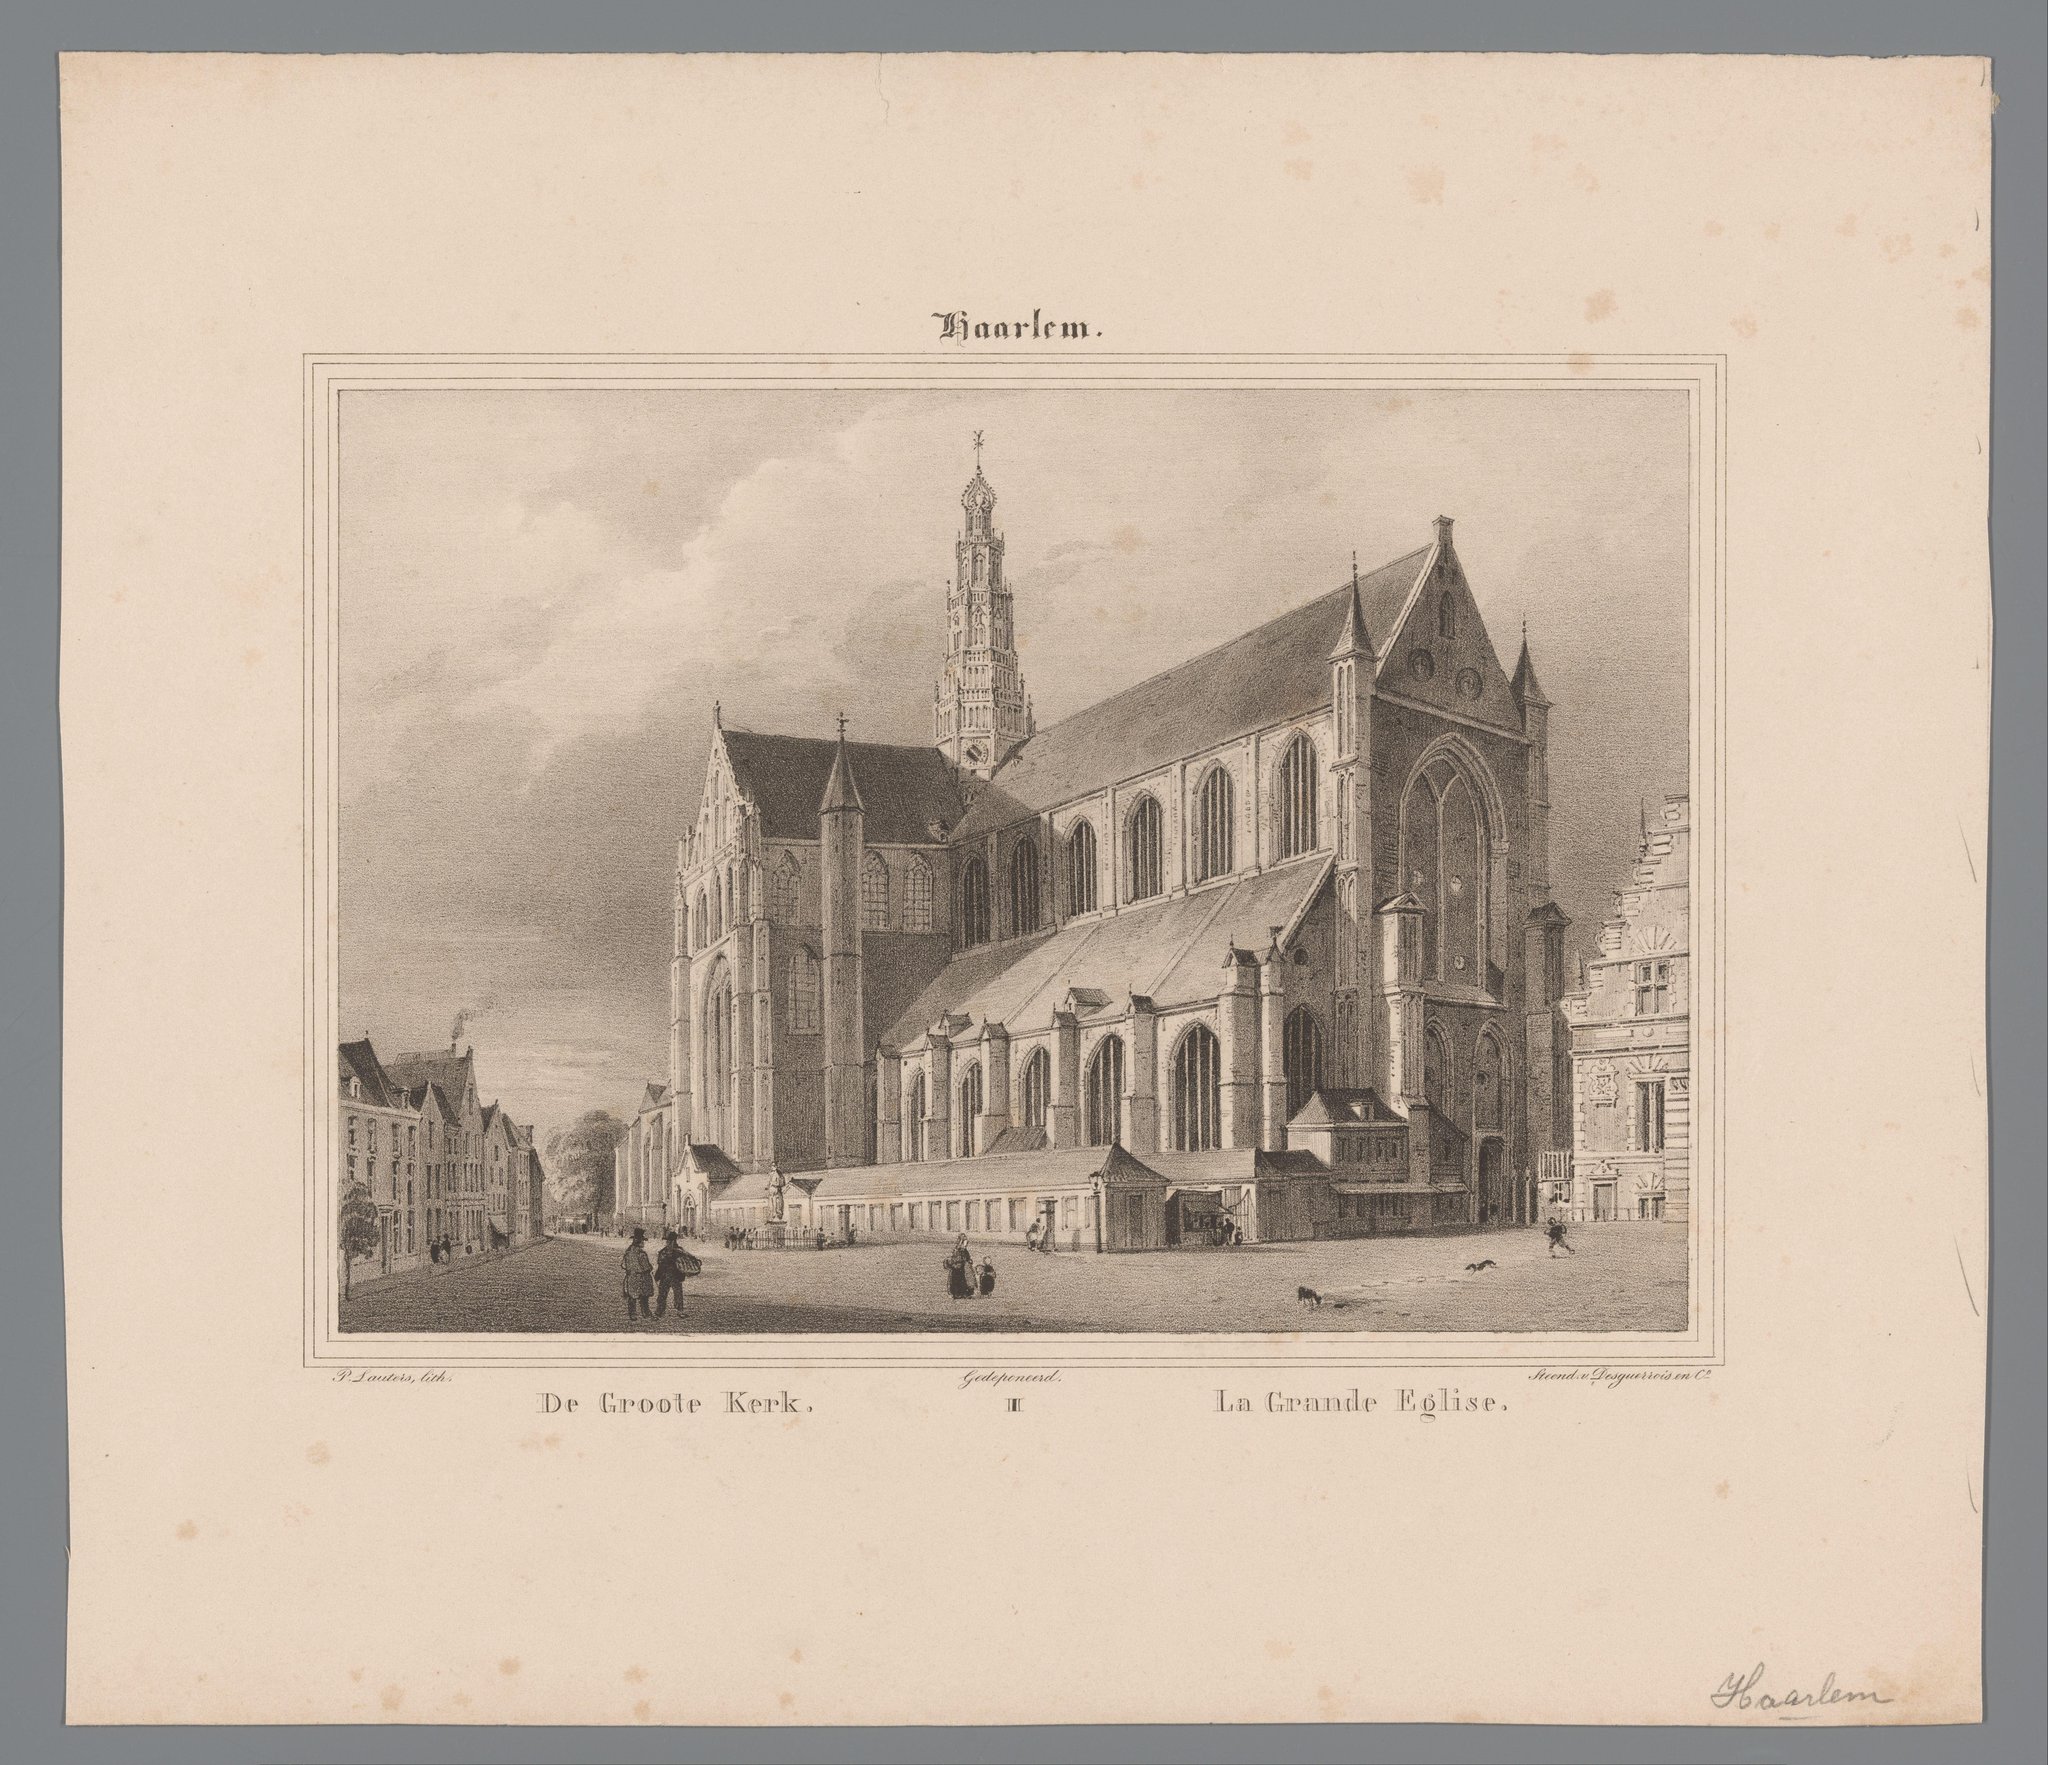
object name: print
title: Haarlem: De Groote Kerk / La Grande Eglise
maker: paulus lauters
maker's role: print maker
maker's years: 1806-1875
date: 1800-1899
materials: paper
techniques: lithograph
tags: church (exterior)